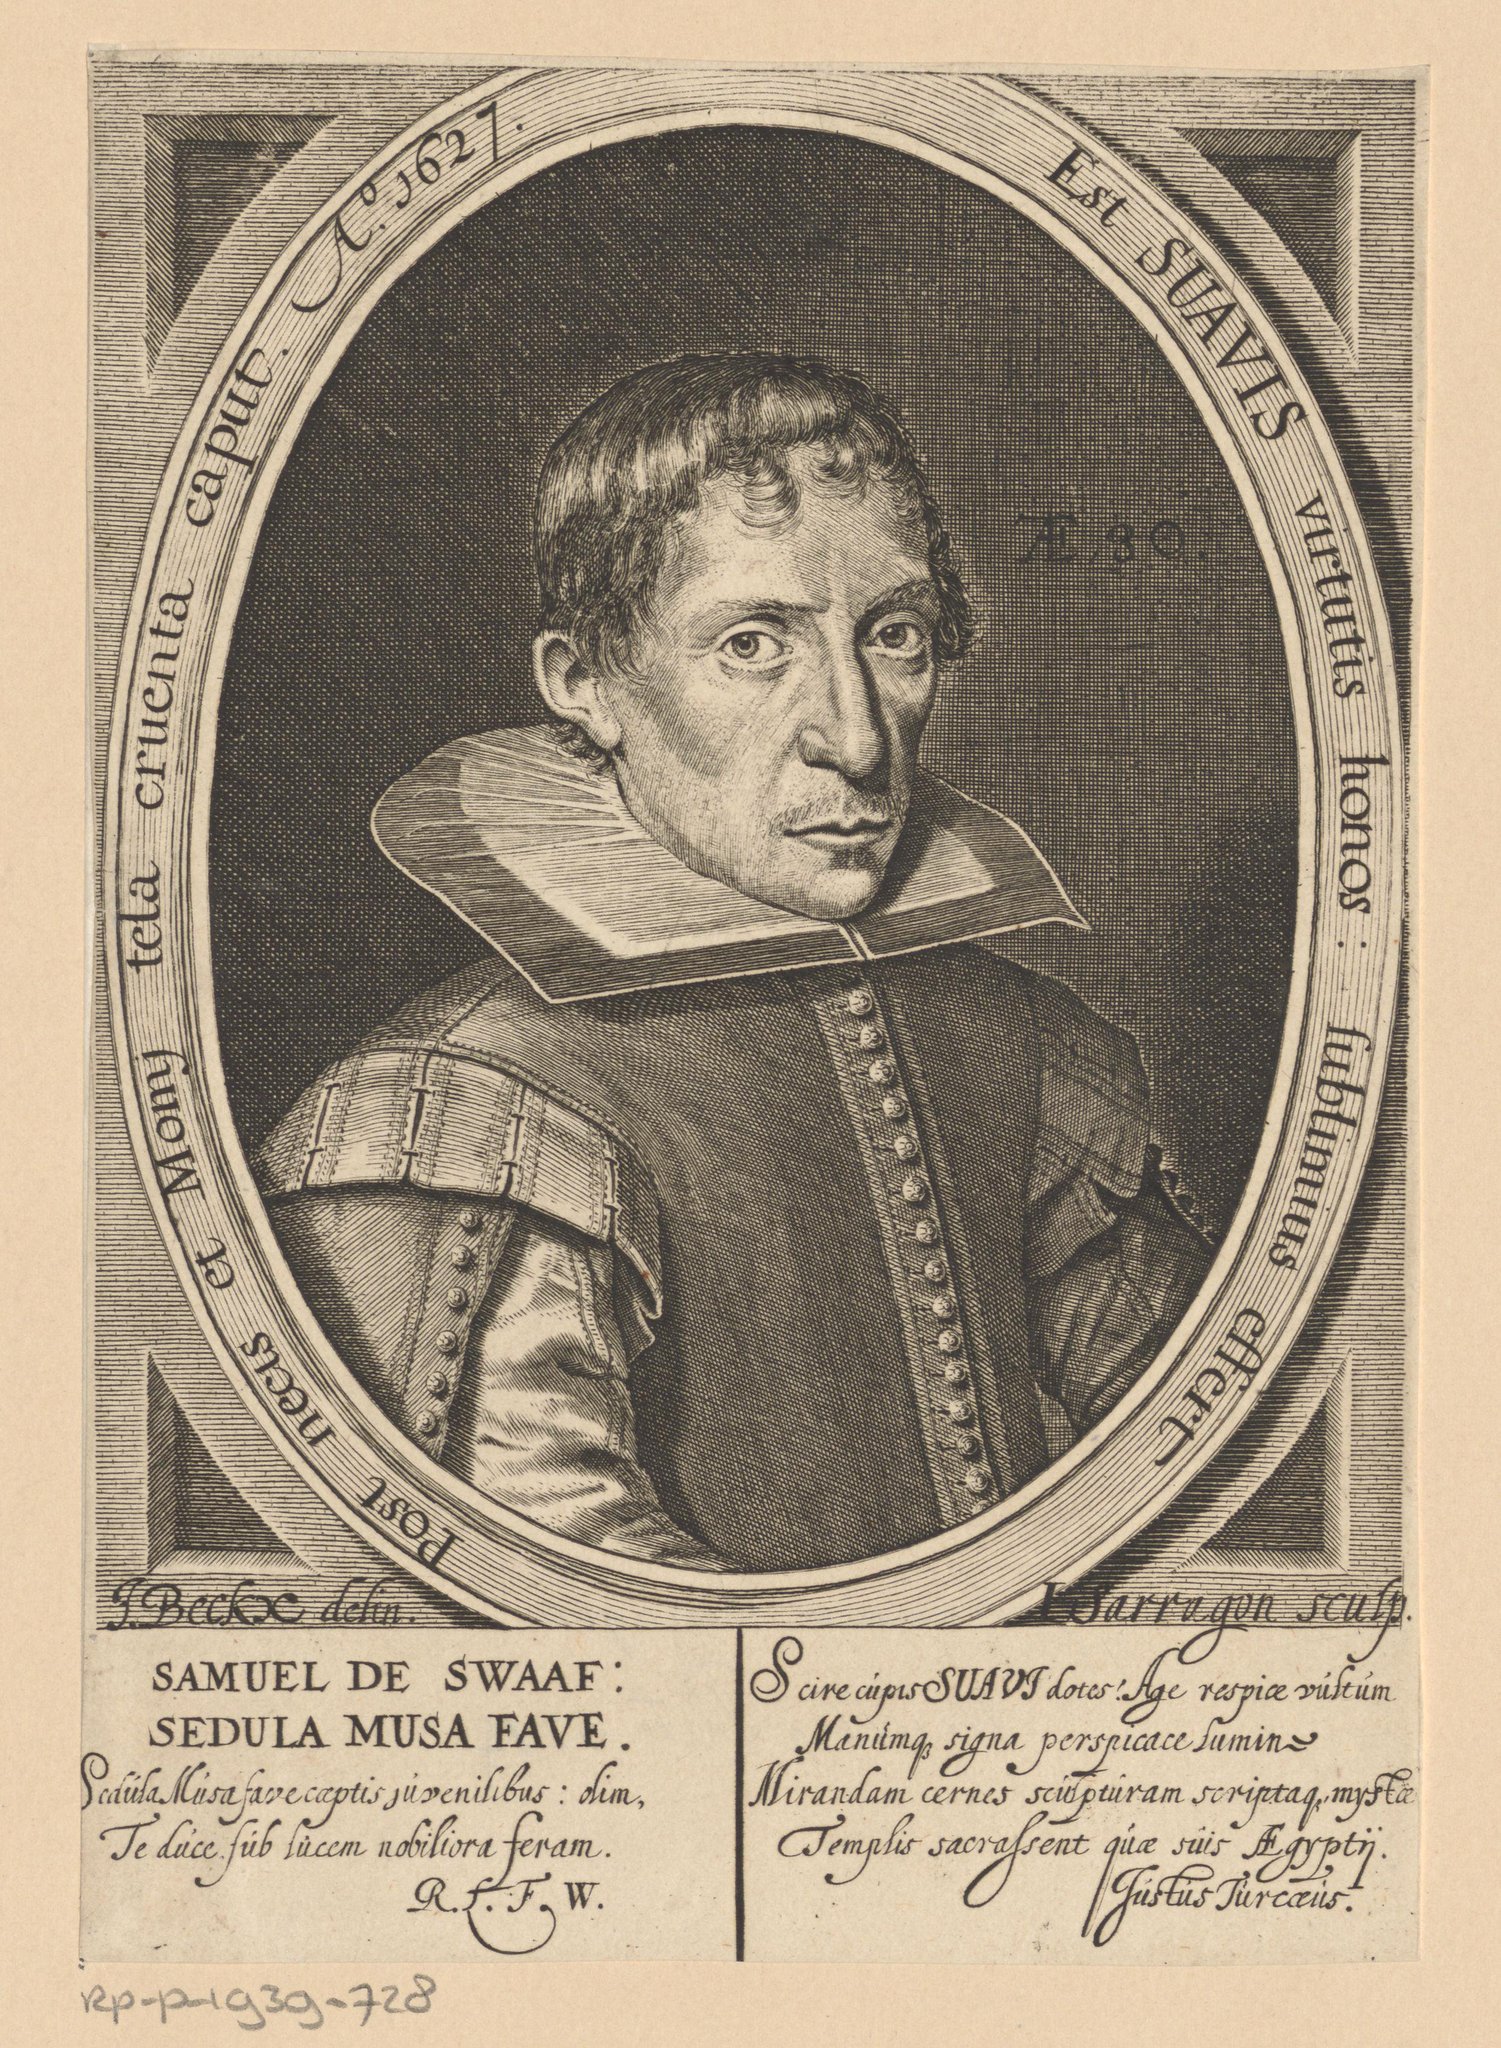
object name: print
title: Portret van Samuel de Swaef op 30-jarige leeftijd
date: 1627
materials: paper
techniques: engraving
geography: middelburg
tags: samuel de swaef, historical persons, portrait of a writer, portrait, self-portrait of graphic artist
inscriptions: collector's mark: Lugt 2028, monogram: ‘RLFW’, collector's mark: Lugt 2166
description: Onder het portret een tweeregelig en een vierregelig lofdicht in het Latijn.